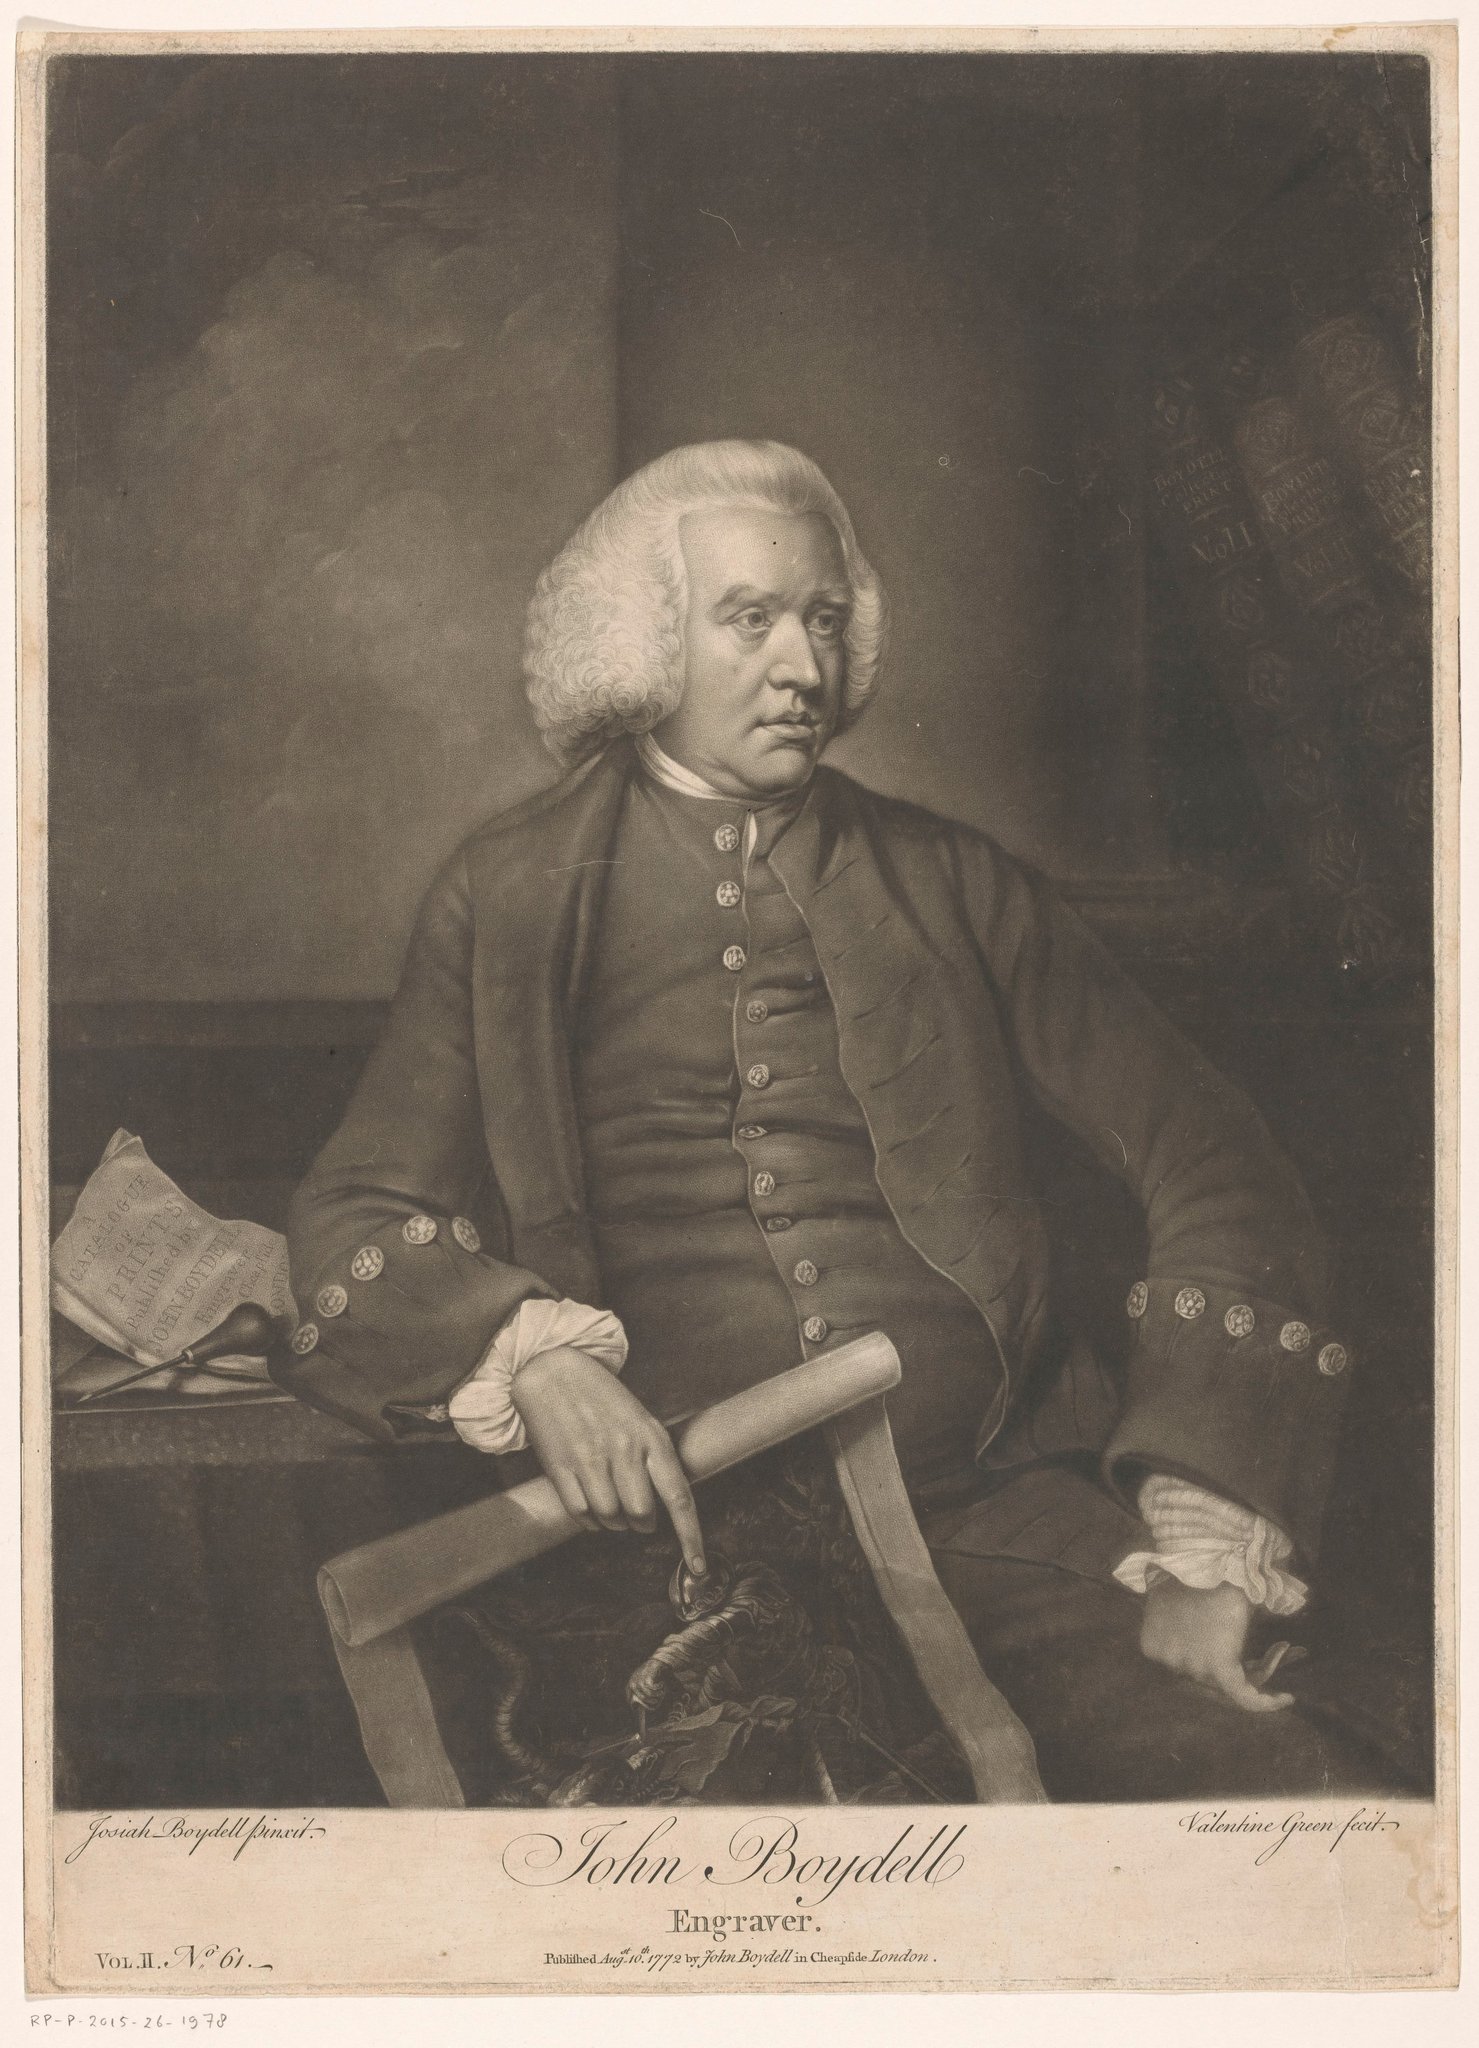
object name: print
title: Portret van John Boydell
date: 1772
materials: paper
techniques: mezzotint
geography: london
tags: london, draughtsman, publisher, john boydell, print, e.g.: engraving, etching, lithograph, tools, implements of graphic artist, portrait, self-portrait of graphic artist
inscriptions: collector's mark: Lugt 4780, collector's mark: Lugt 2228, collector's mark: Lugt 4779, annotation: ‘£ 10 -’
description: Portret van de Engelse prentmaker John Boydell met in zijn handen een prent met Jason en de Draak naar Salvator Rosa. Naast hem op tafel liggen een titelpagina en een burijn. In de achtergrond staan banden met zijn verzameld prentwerk in de kast. Linksonder genummerd: Vol. II, No. 61.